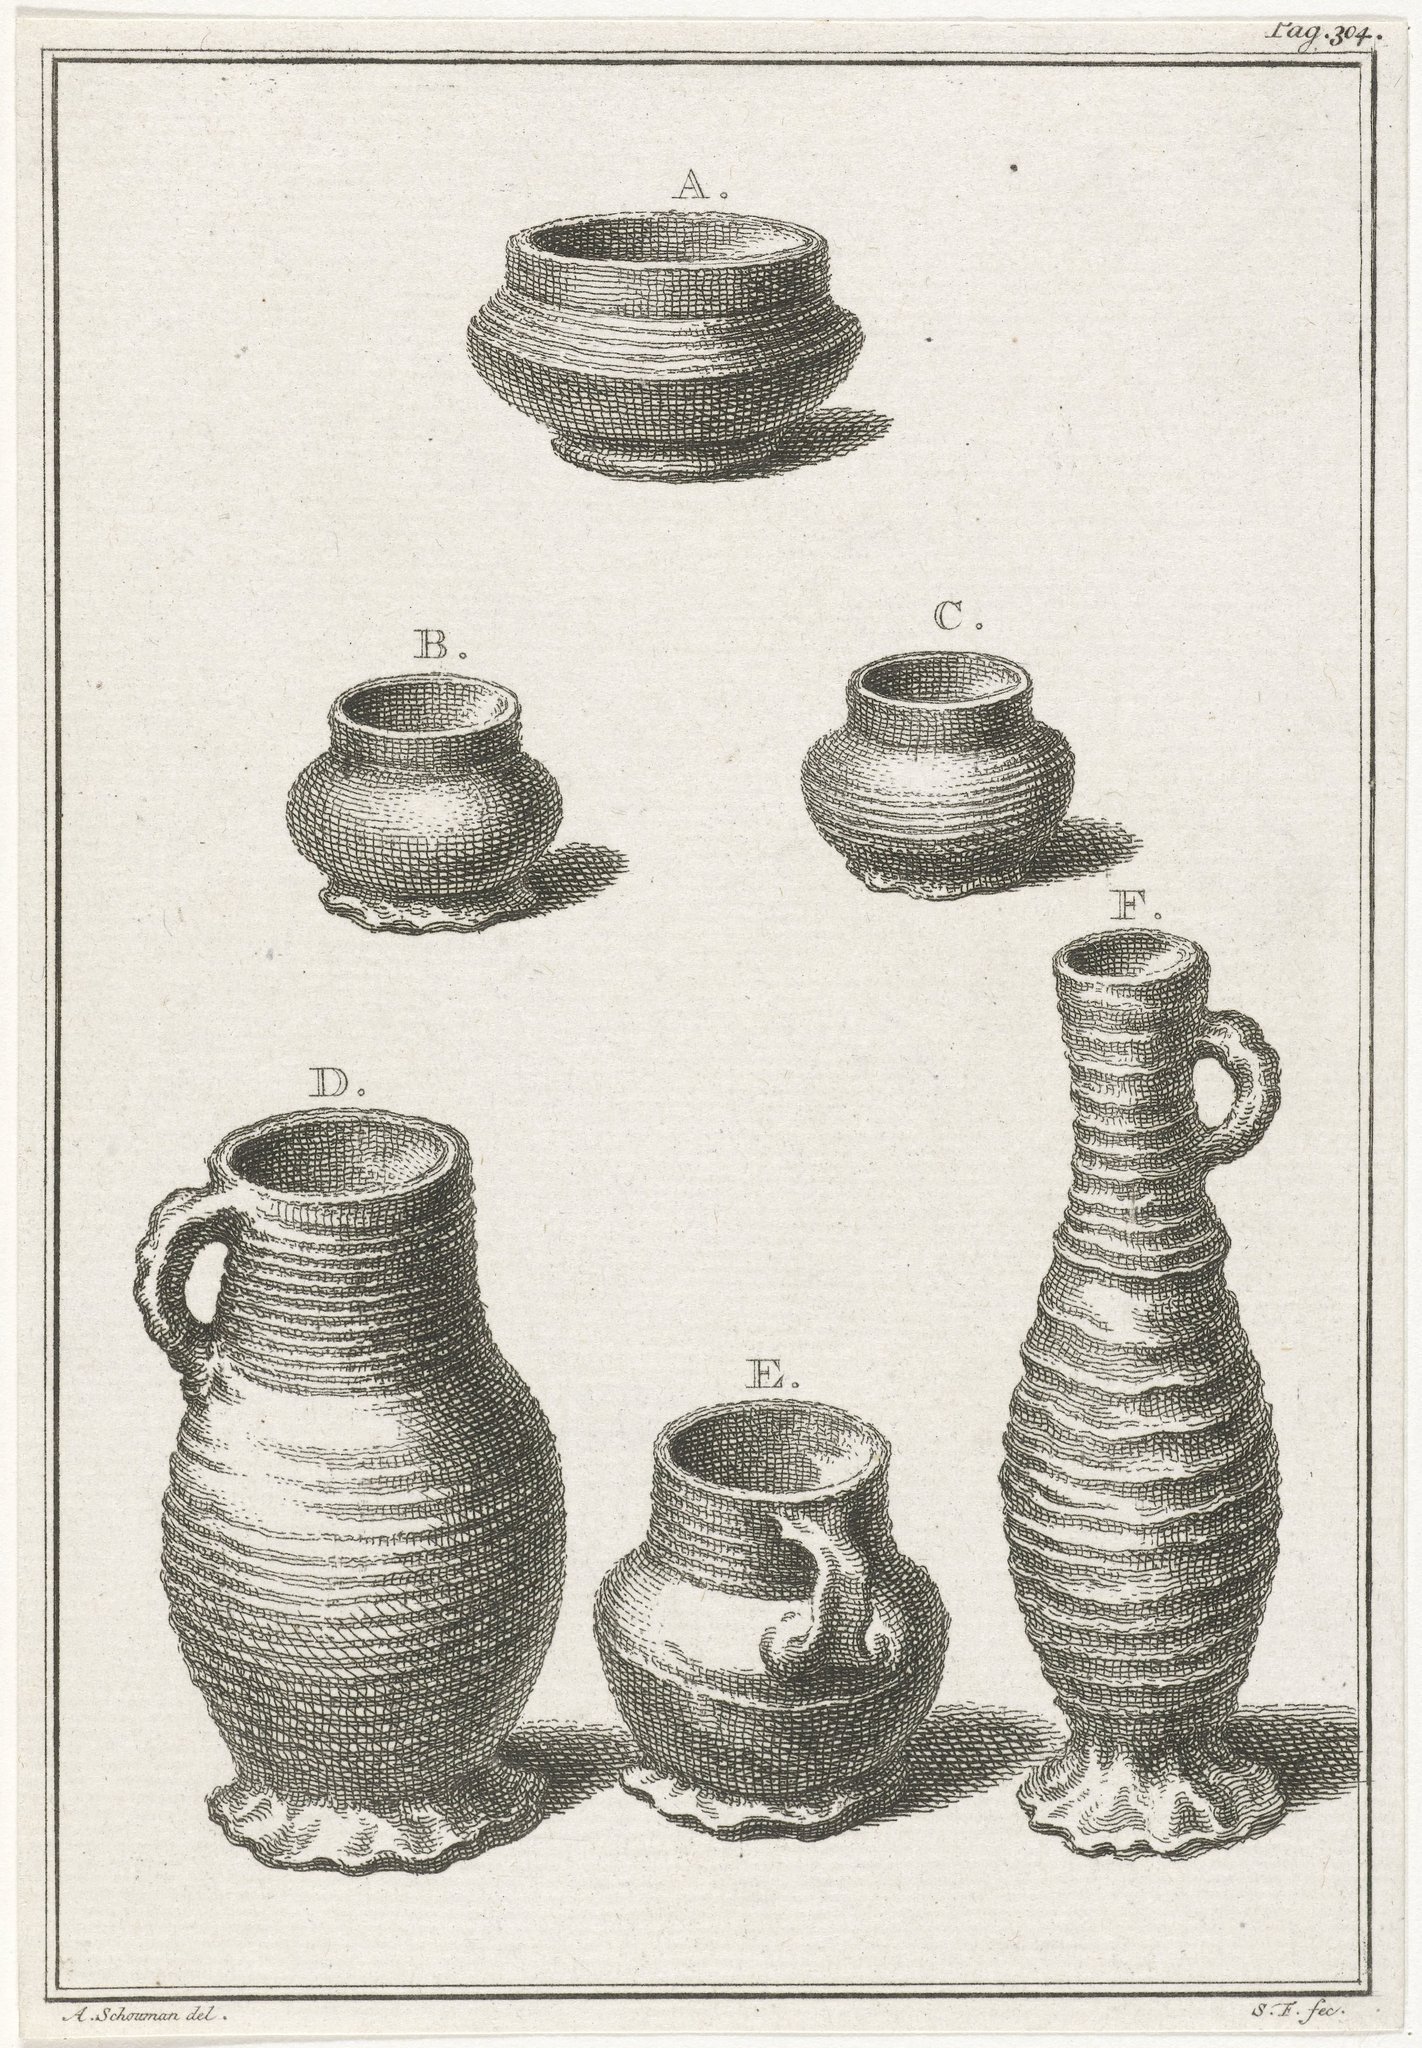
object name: print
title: Drie potten en drie vazen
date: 1722-1784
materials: paper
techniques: etching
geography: amsterdam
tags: containers (+ stone)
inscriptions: collector's mark: Lugt 2228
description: Weergave van drie potten en drie vazen, diverse soorten, A t/m F. Rechtsboven gemerkt: Pag. 304